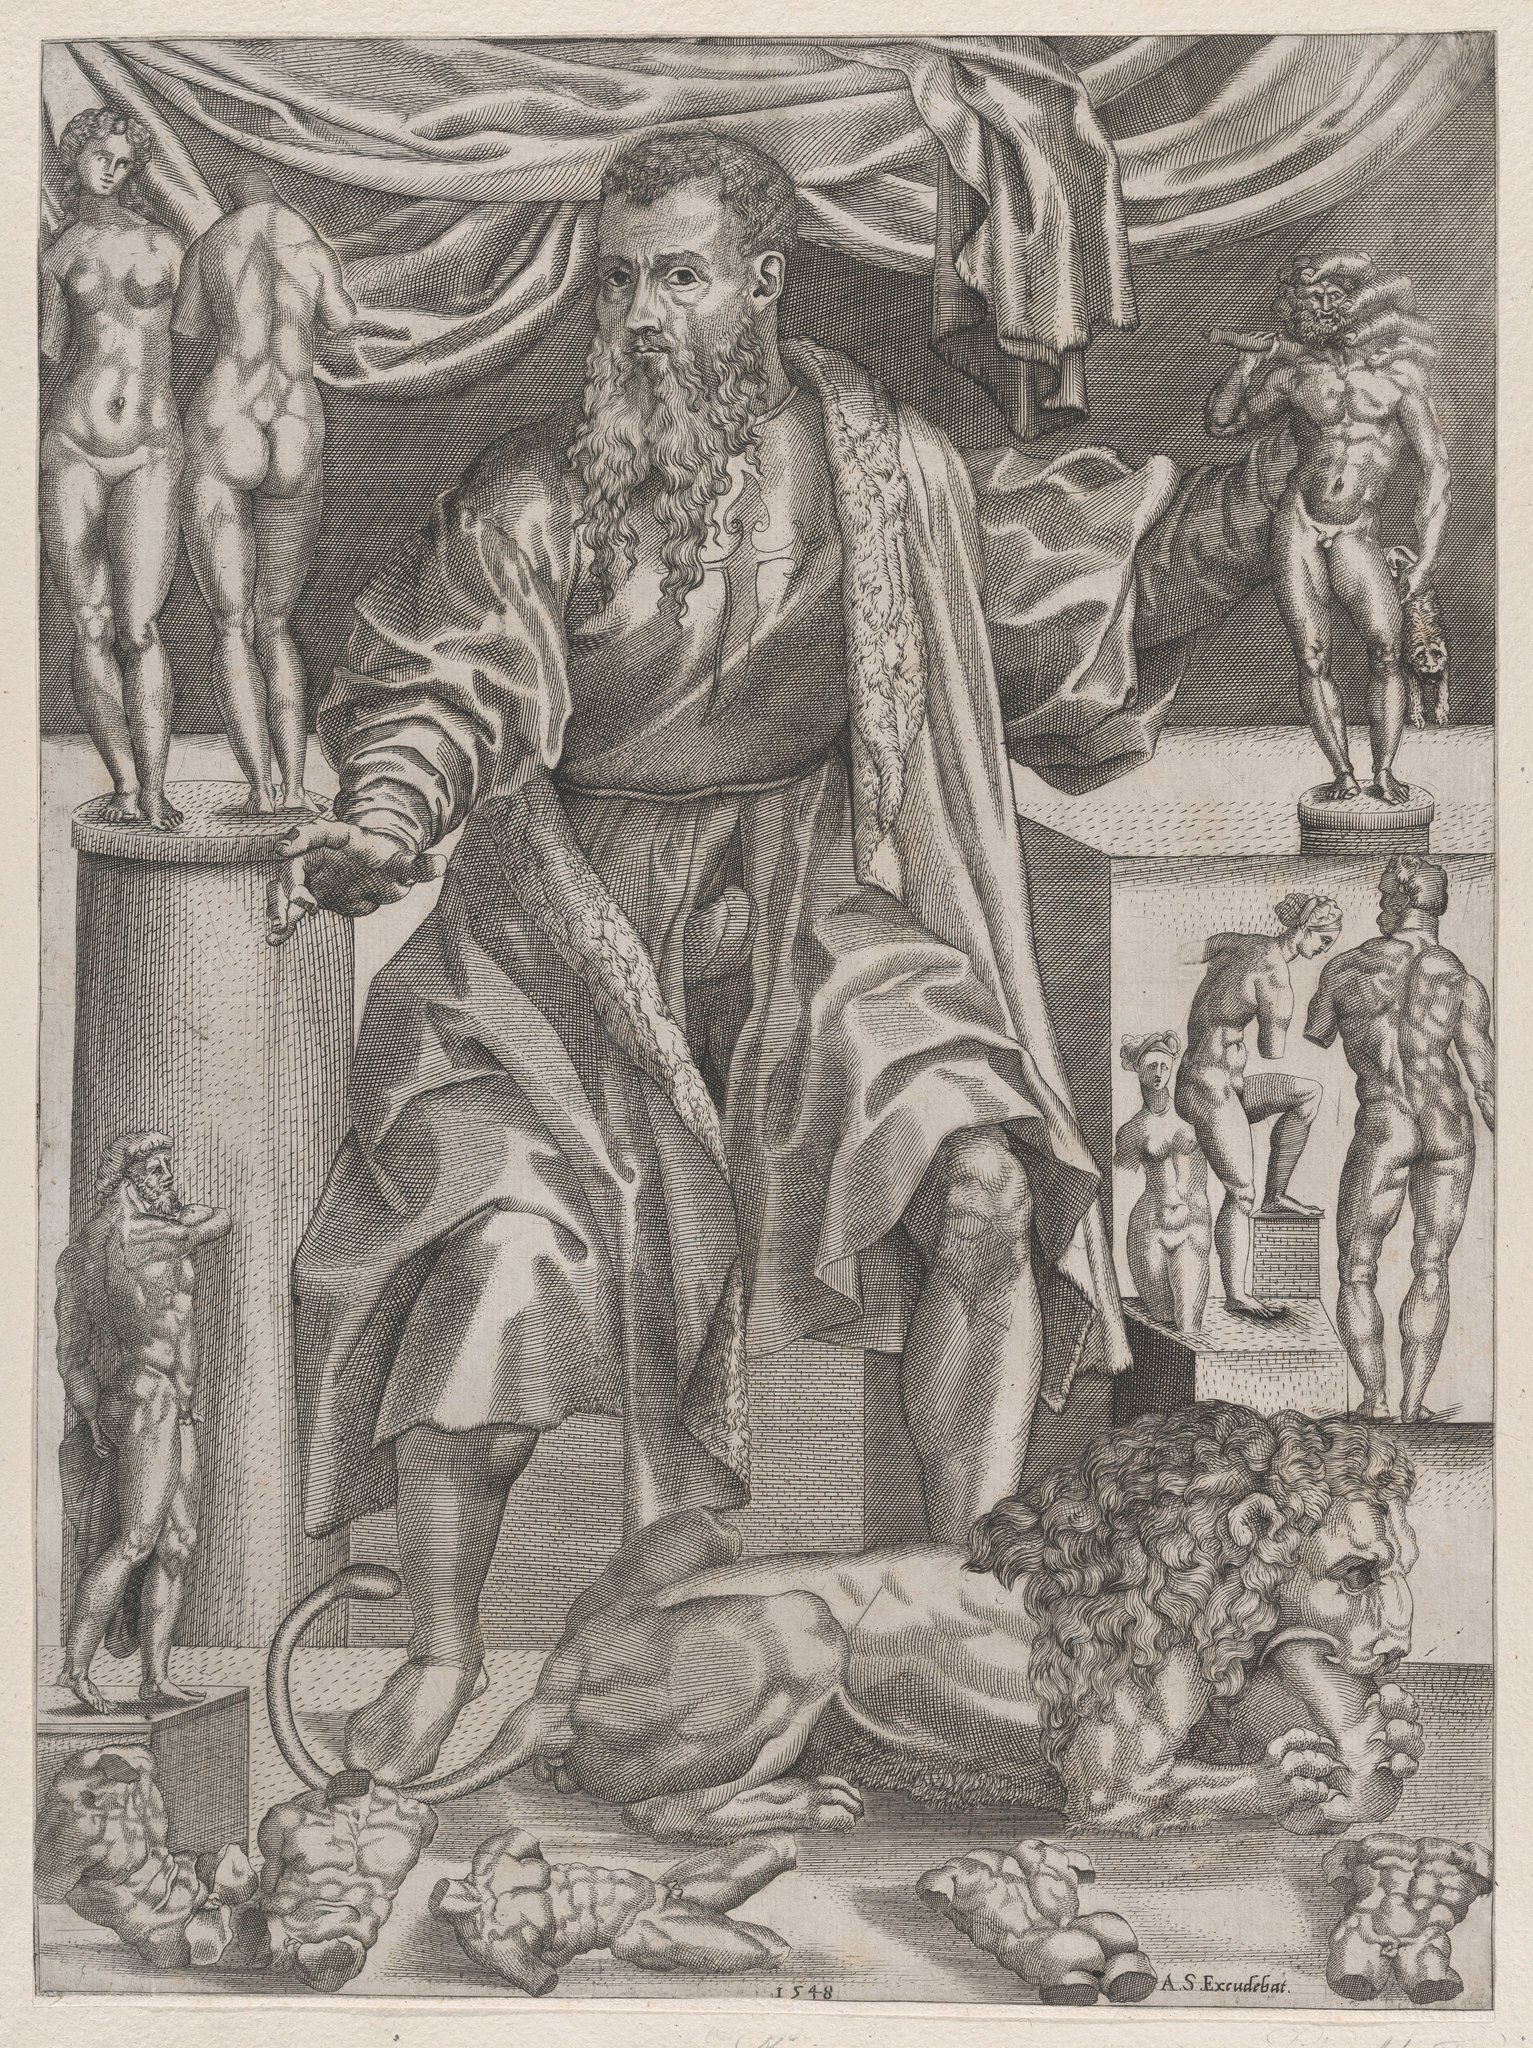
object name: print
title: Portrait of Baccio Bandinelli with Lion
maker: anonymous, 16th century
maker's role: artist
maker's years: 1500-1600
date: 1548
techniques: engraving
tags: men,male nudes,portraits,female nudes,lions